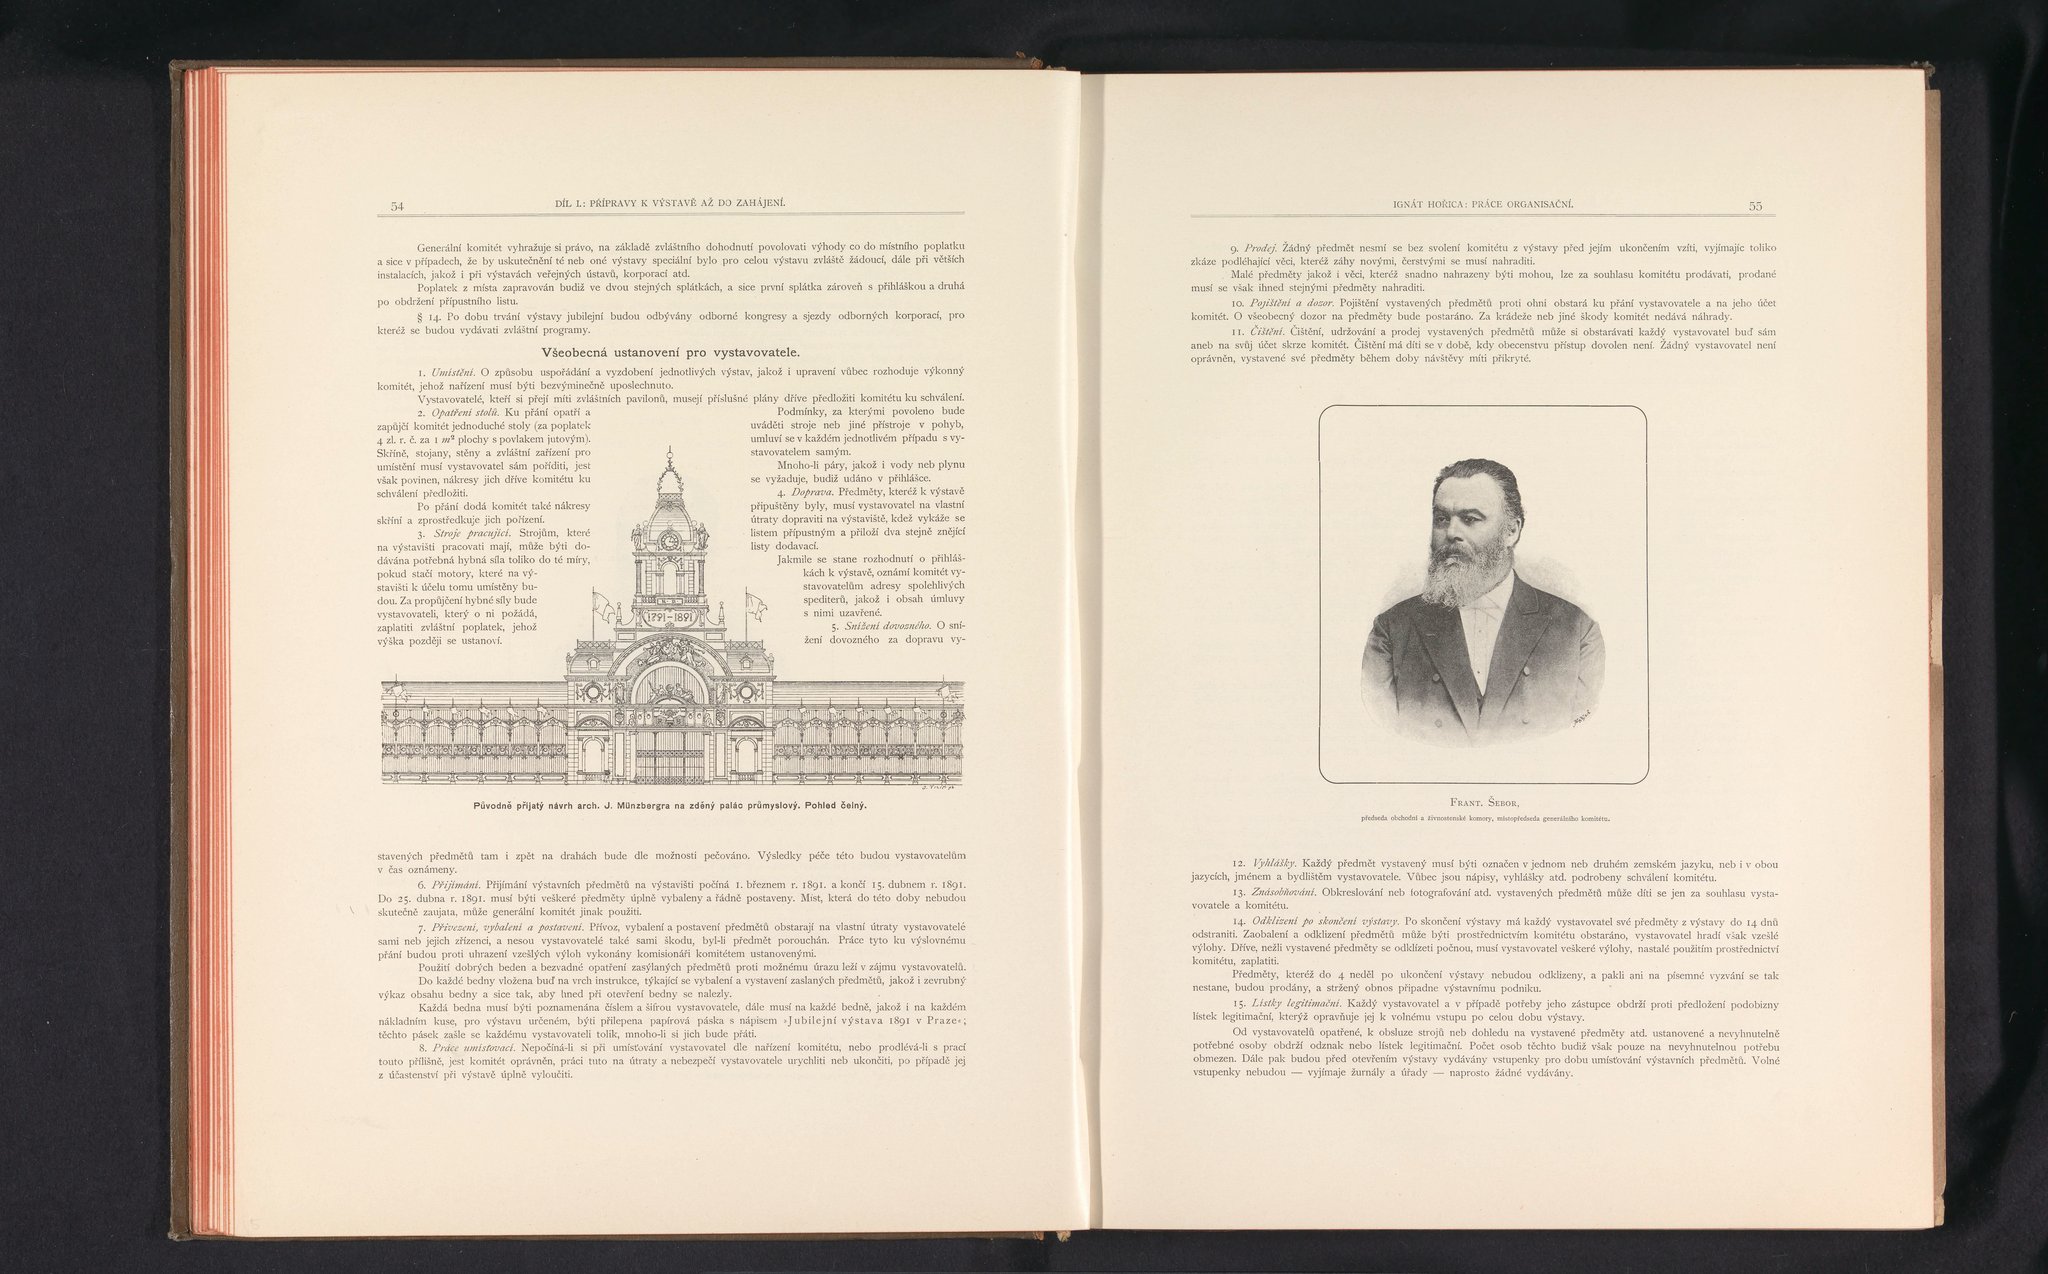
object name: photomechanical print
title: Frant. Šebor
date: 1888-1893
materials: paper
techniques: autotype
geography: prague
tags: adult man